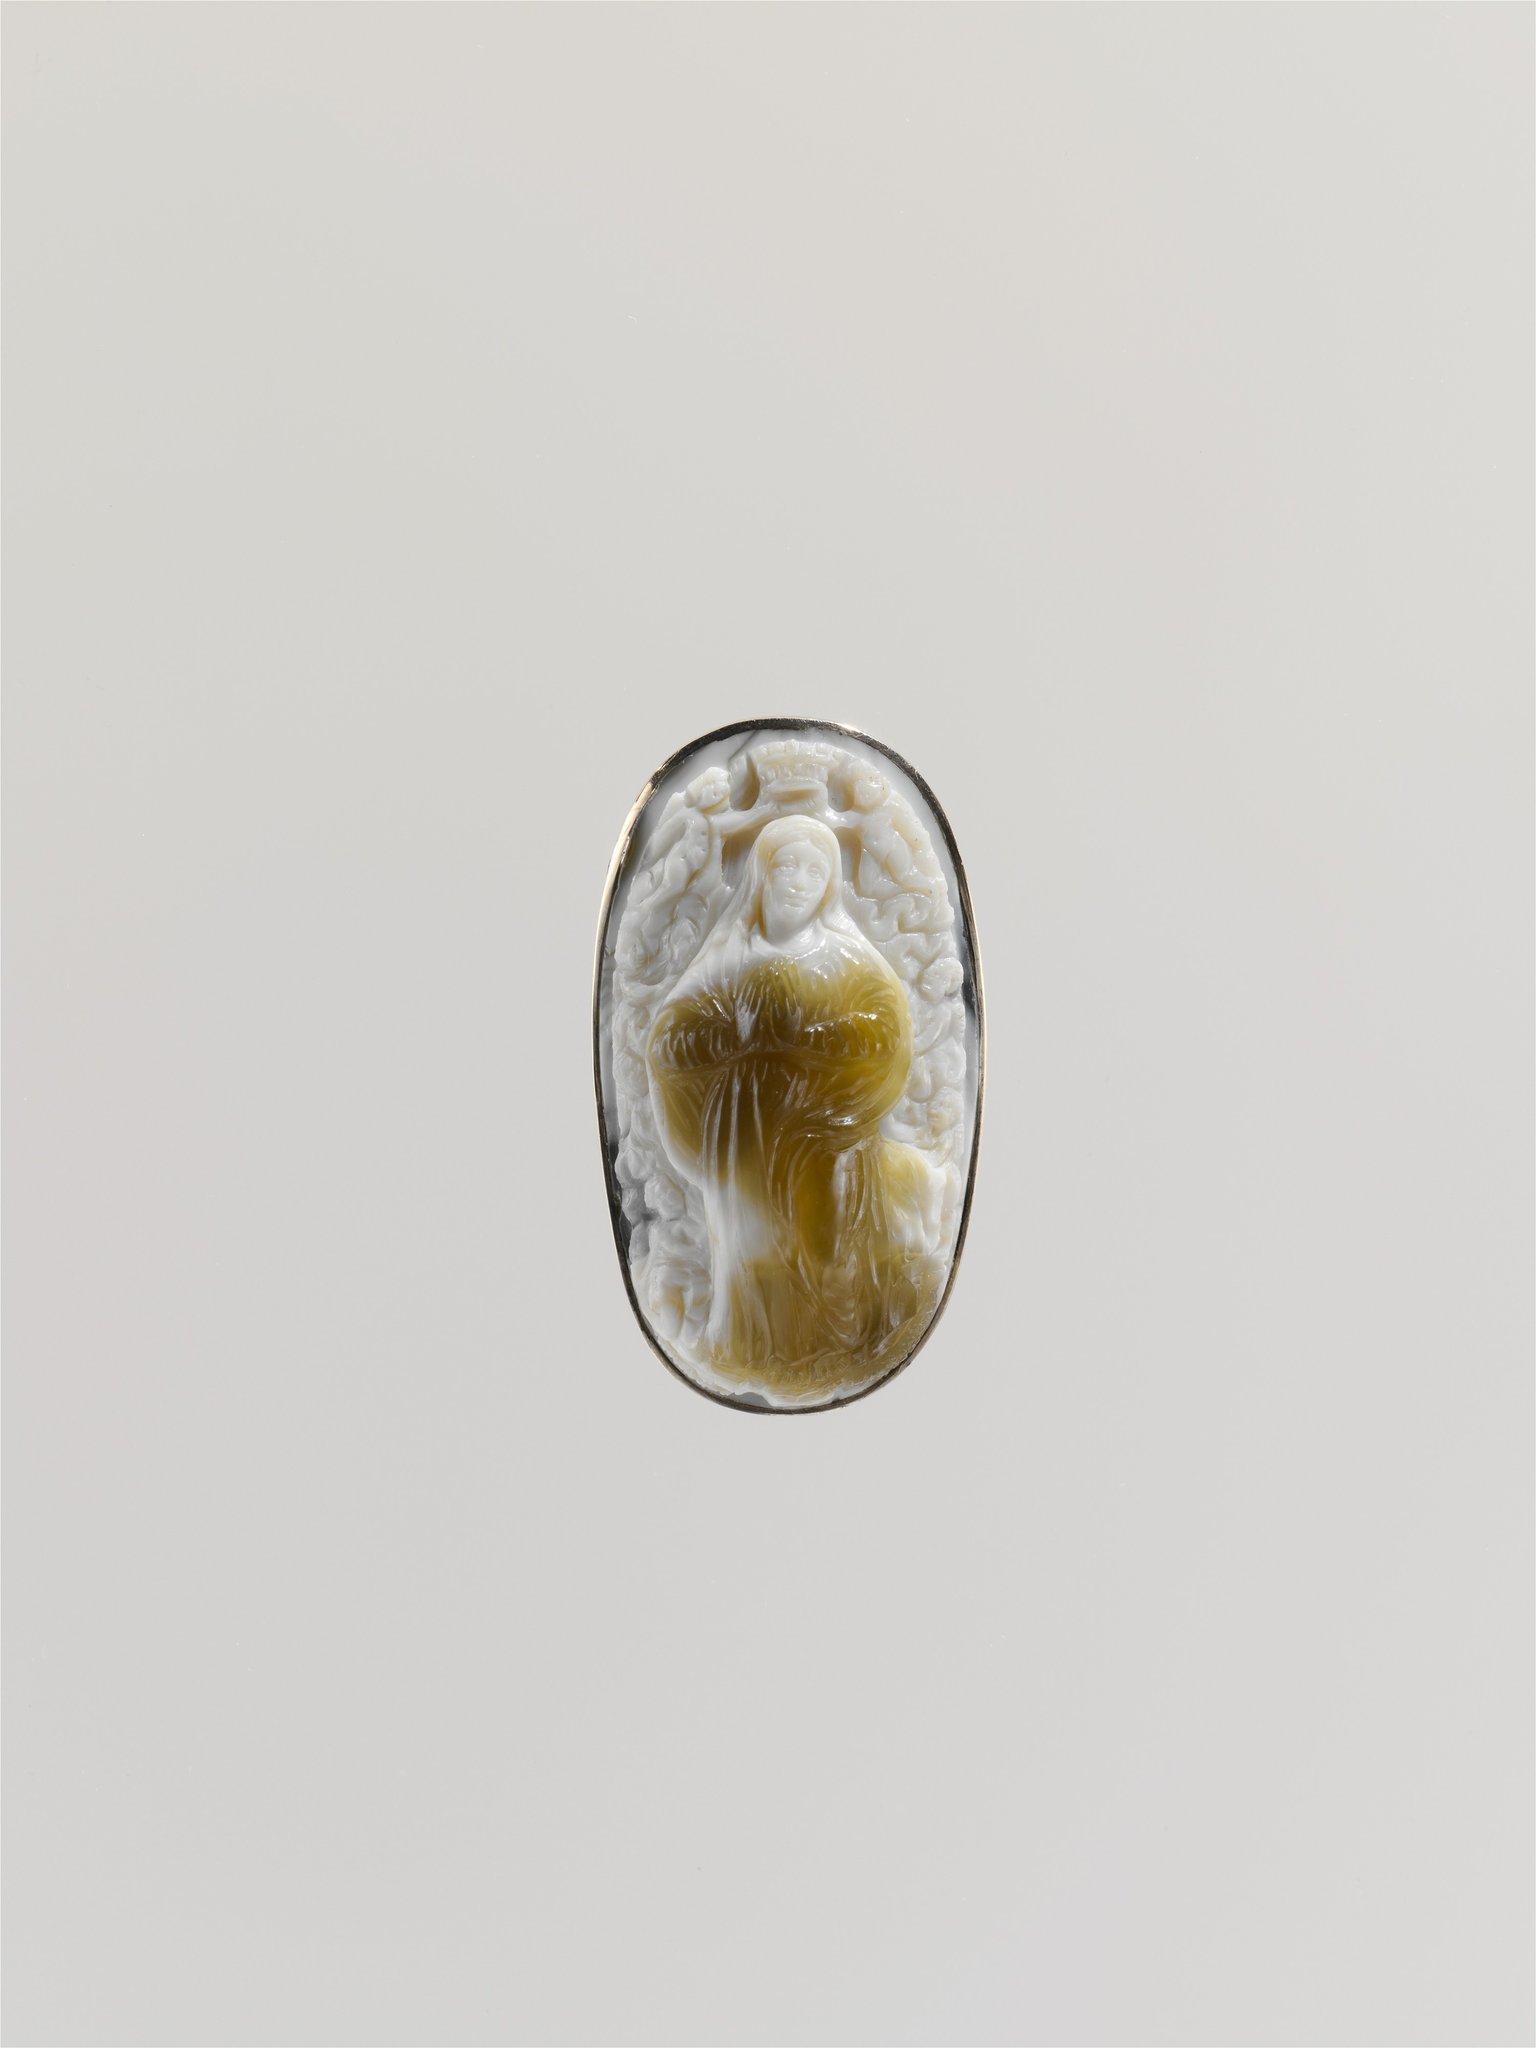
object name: cameo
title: Coronation of the Virgin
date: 1567-1633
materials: gold, onyx, gemstone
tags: angels,virgin mary